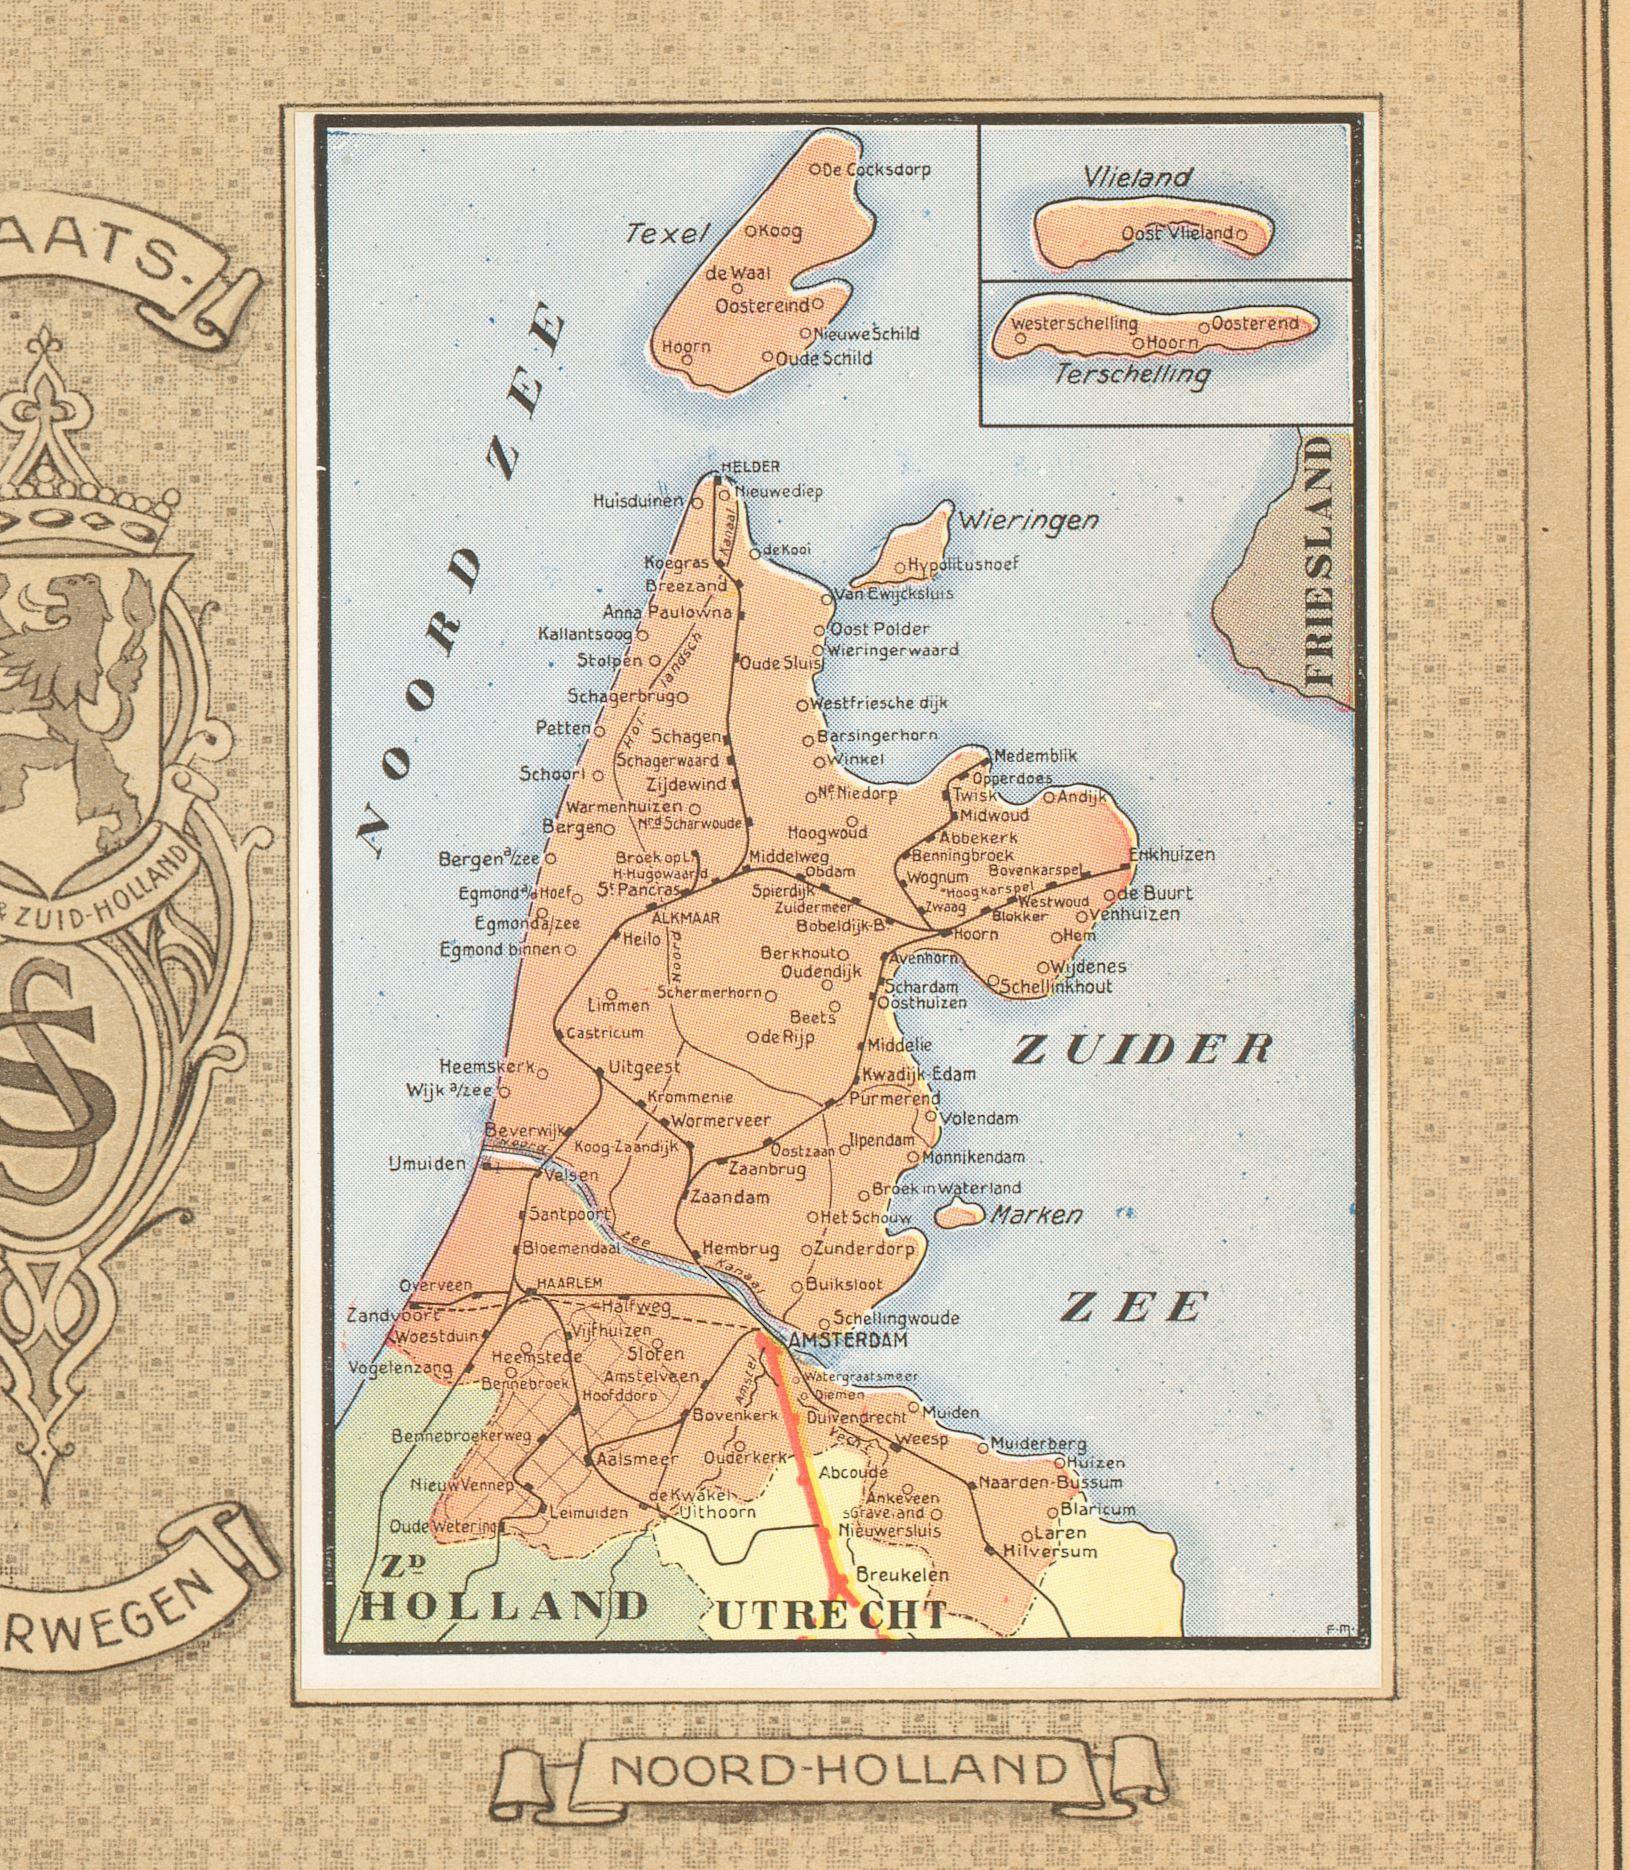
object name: photomechanical print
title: Spoorwegenkaart van Noord-Holland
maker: Anonymous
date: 1915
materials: paper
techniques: printing block, rotogravure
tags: maps of separate countries or regions, railway, tramway; rack railway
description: Deze prent maakt deel uit van een album.